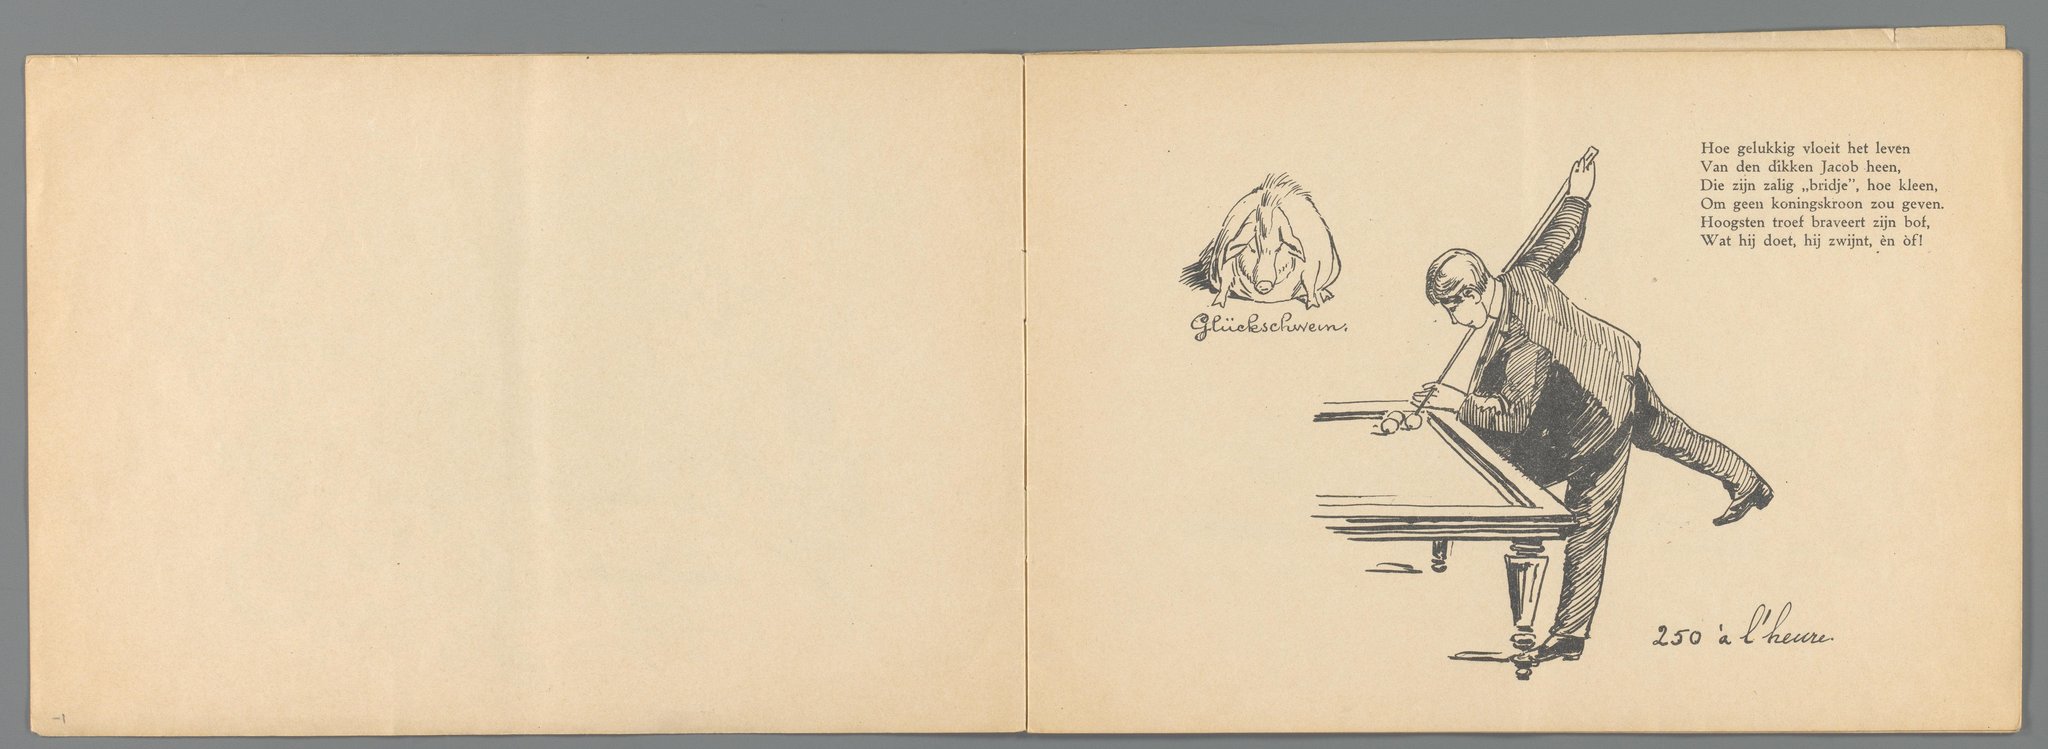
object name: print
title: Jakob Gijsbert de Hoop Scheffer aan een biljart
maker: Anonymous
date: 1910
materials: paper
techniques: lithograph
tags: amsterdam, billiards, pig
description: Bij gebrek aan gegevens over de vervaardiger is voor de bepaling van de rechten van dit object gebruik gemaakt van de vervaardigingsdatum.